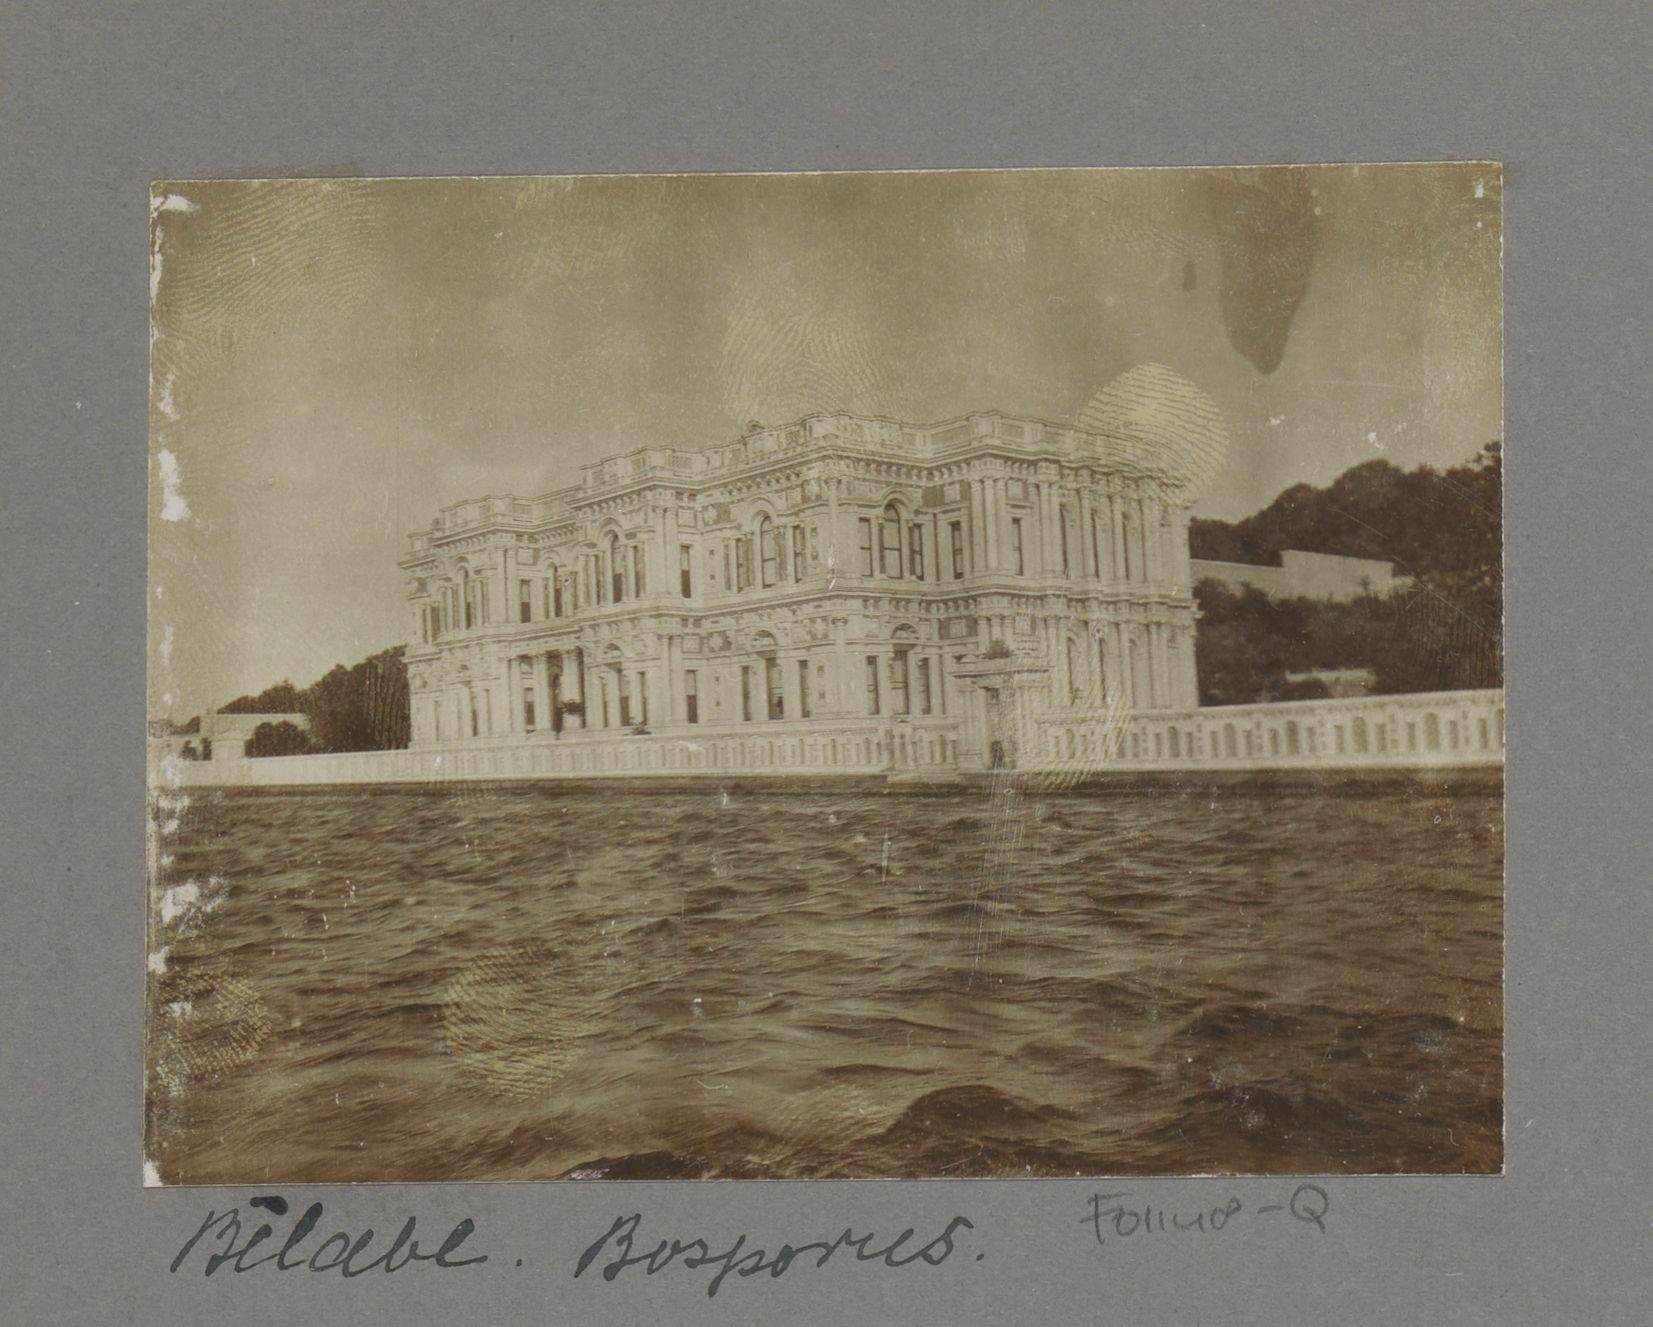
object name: photograph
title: Gezicht op het Küçüksu Paleis aan de Bosporus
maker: Anonymous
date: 1905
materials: paper, photographic support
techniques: collodion silver print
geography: bosporus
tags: palace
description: Onderdeel van Reisalbum met foto's van bezienswaardigheden in Griekenland en Egypte.